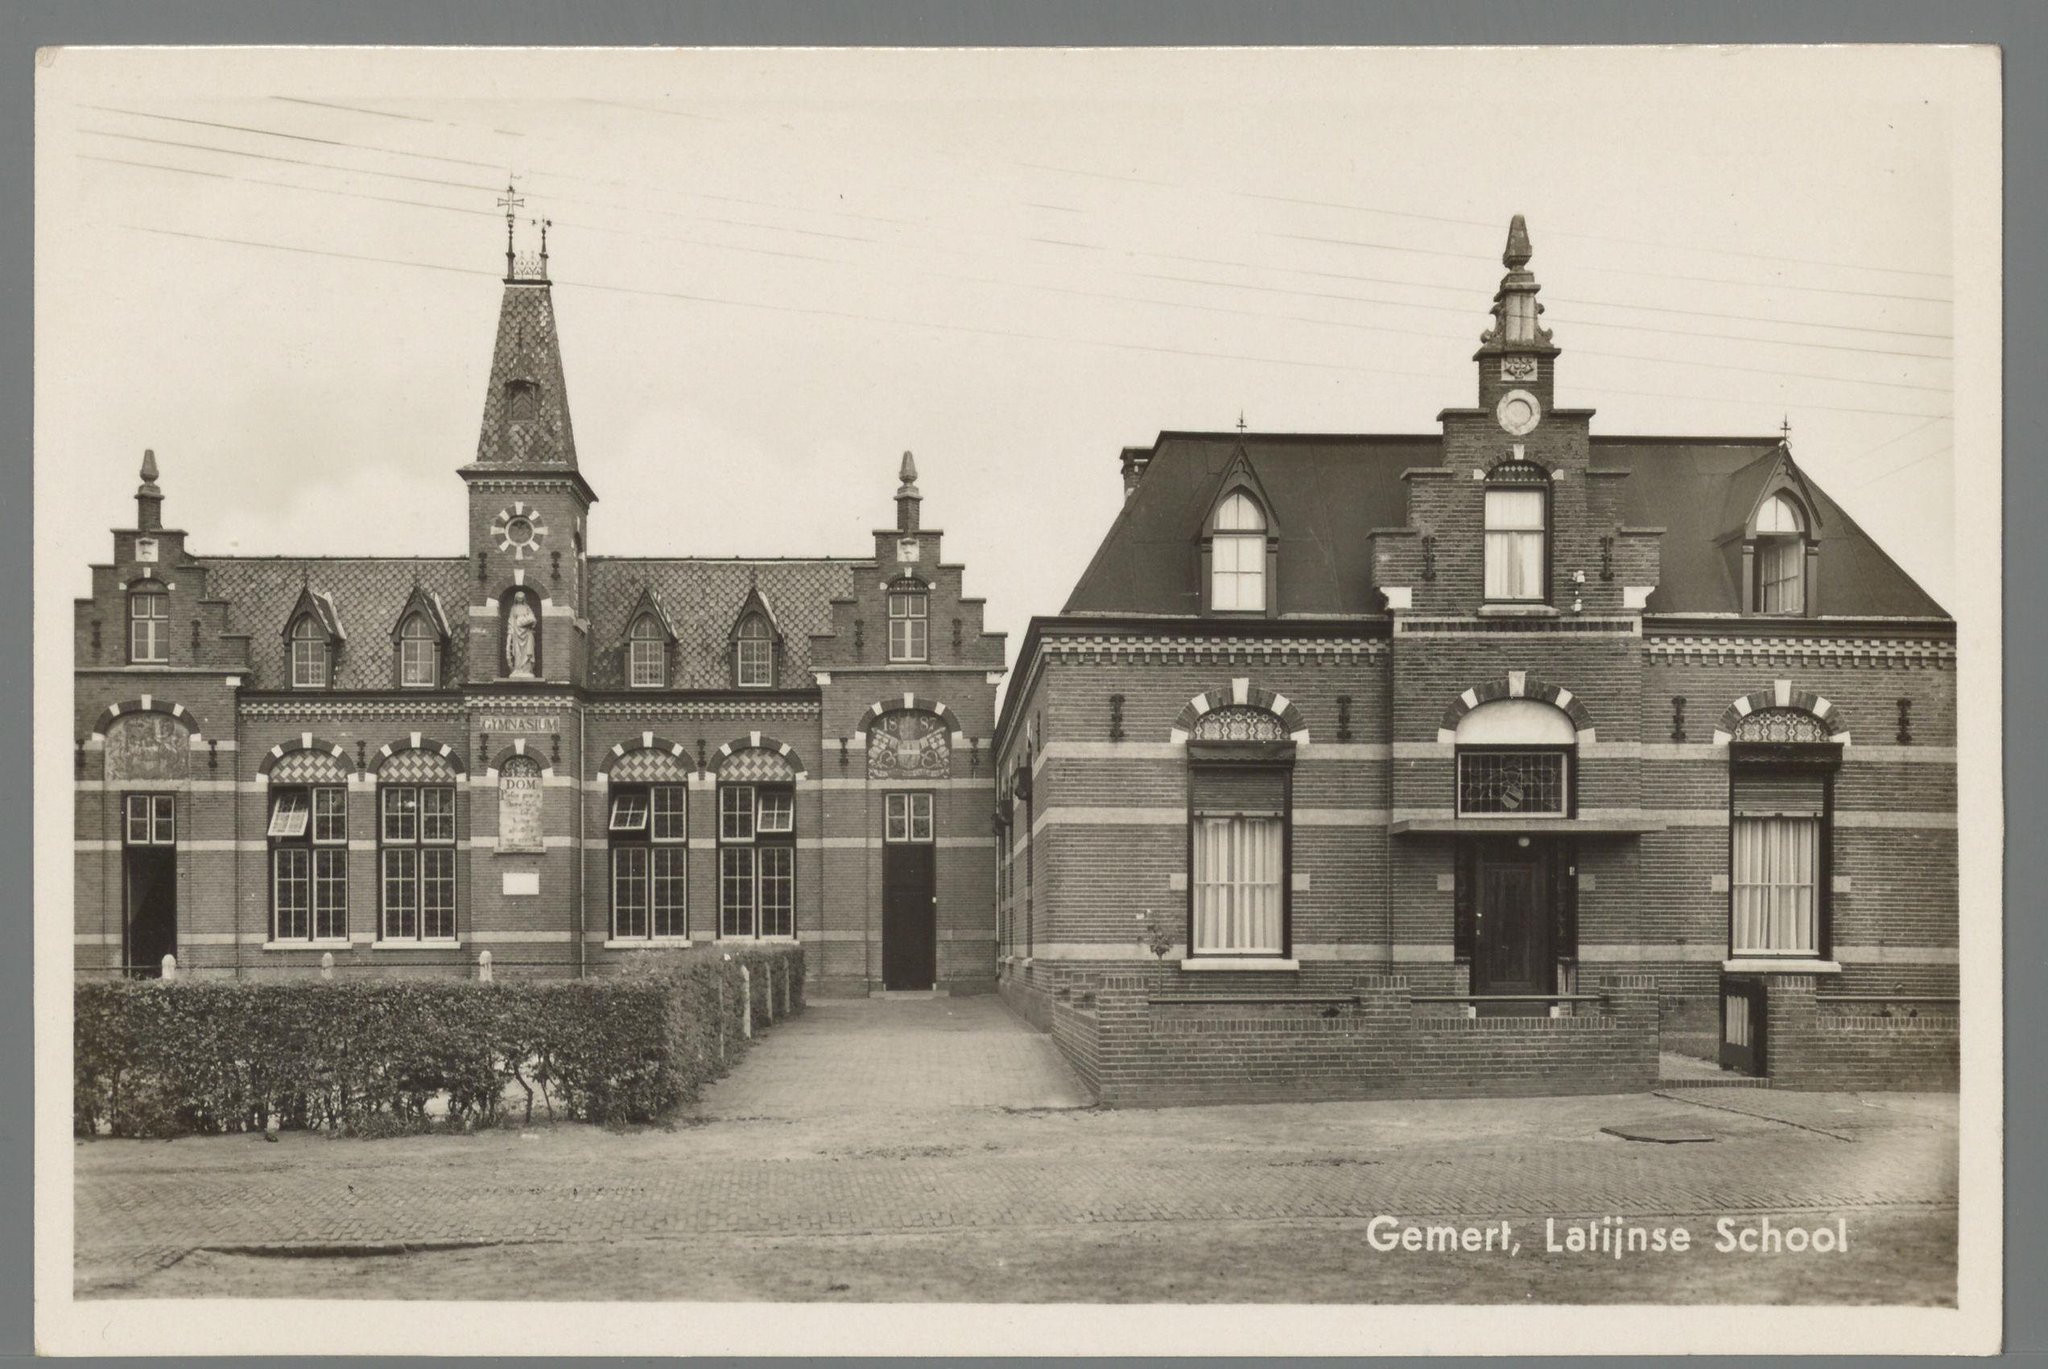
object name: ansichtkaart, prentbriefkaart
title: Gemert, Latijnse School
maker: Anonymous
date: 1912-1939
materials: paper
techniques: gelatin silver print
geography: gemert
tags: university building, college, gemert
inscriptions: date